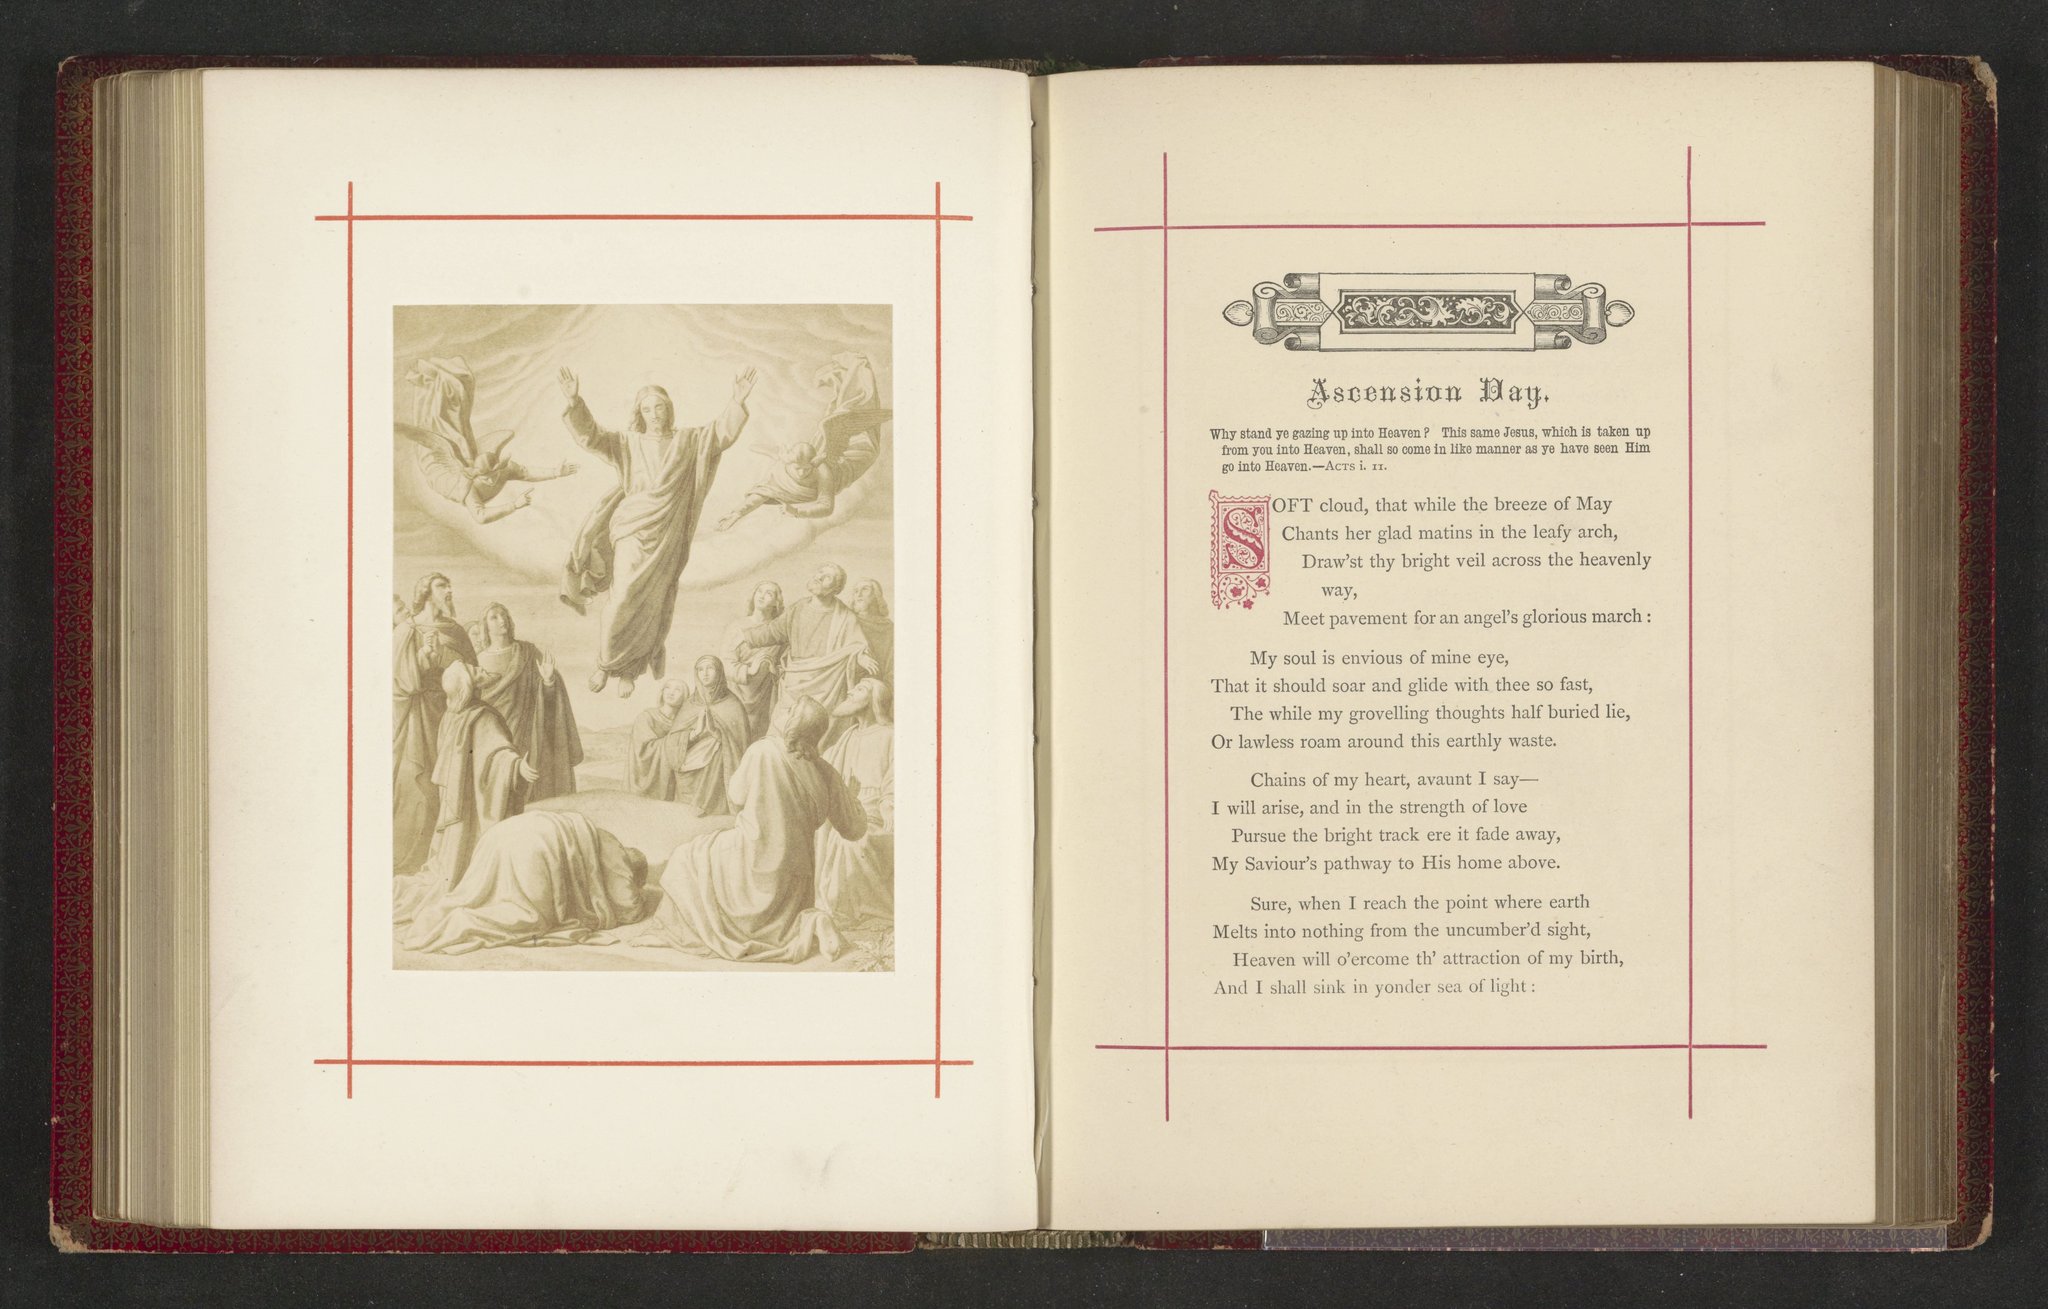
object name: page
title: Fotoreproductie van een prent, voorstellende de hemelvaart van Christus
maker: Anonymous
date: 1868-1873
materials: photographic support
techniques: albumen print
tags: christ aloft in the sky ~ ascension